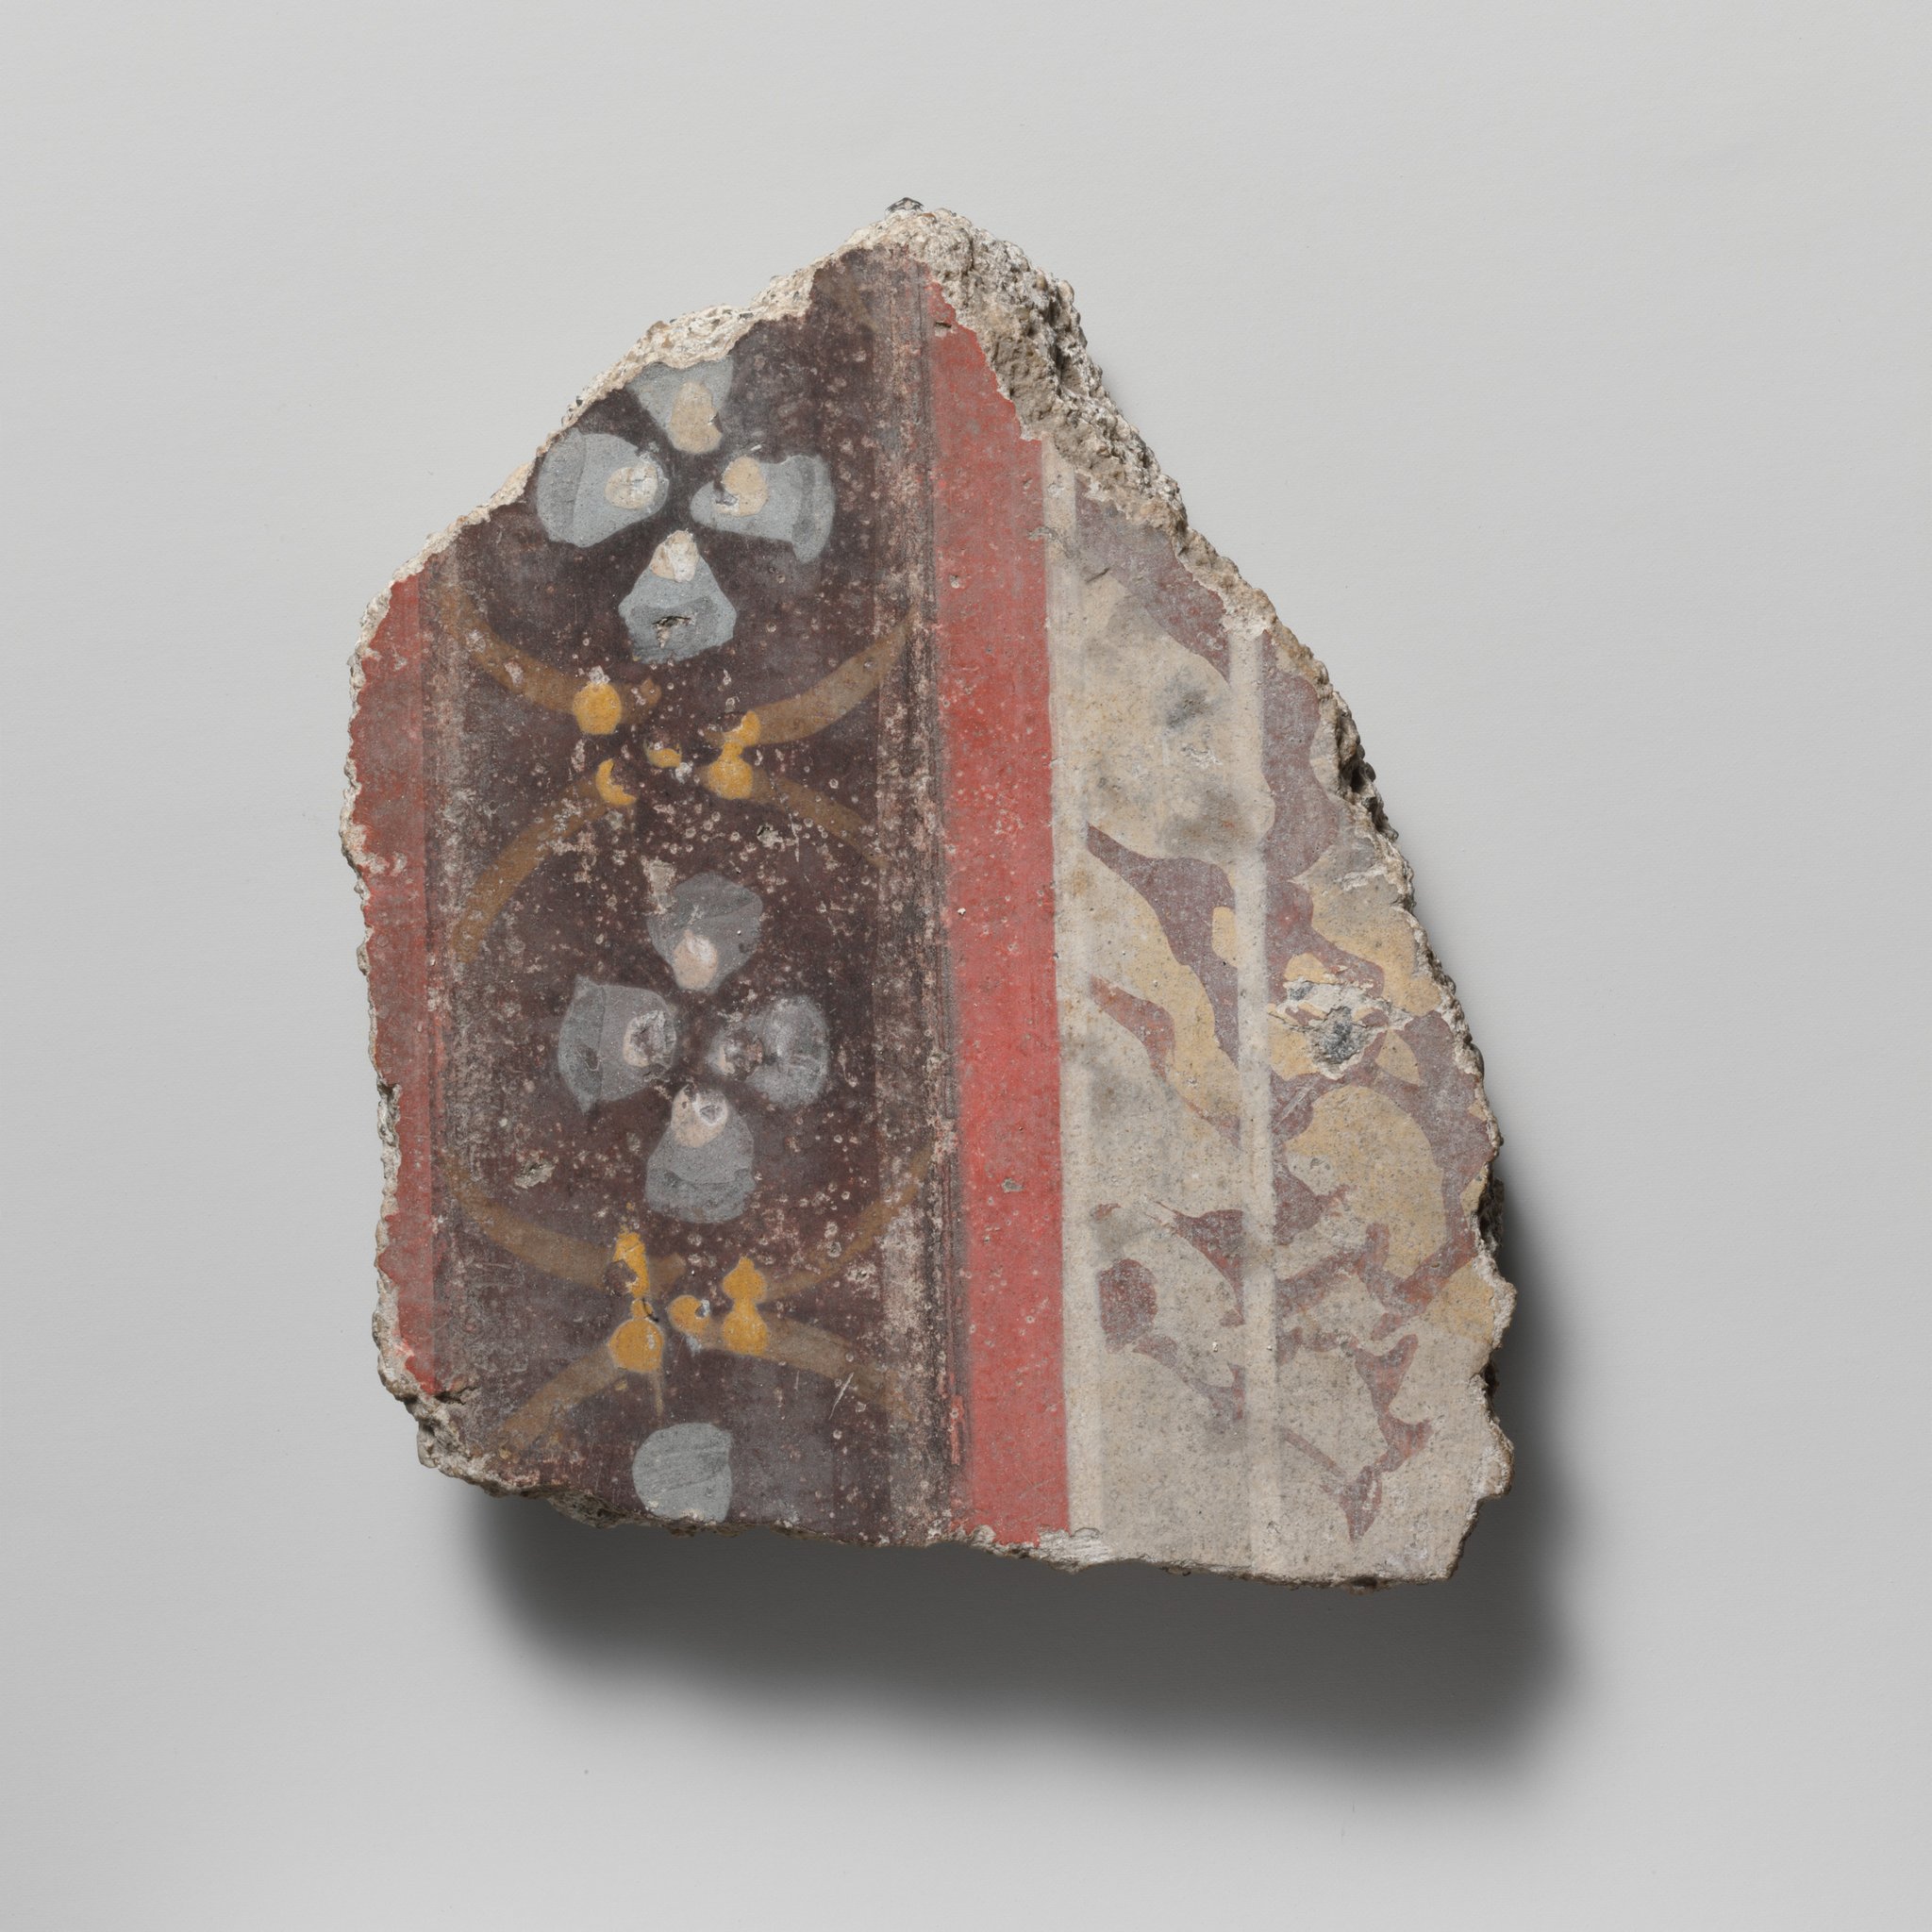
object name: wall painting fragment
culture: roman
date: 1-100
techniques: fresco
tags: flowers